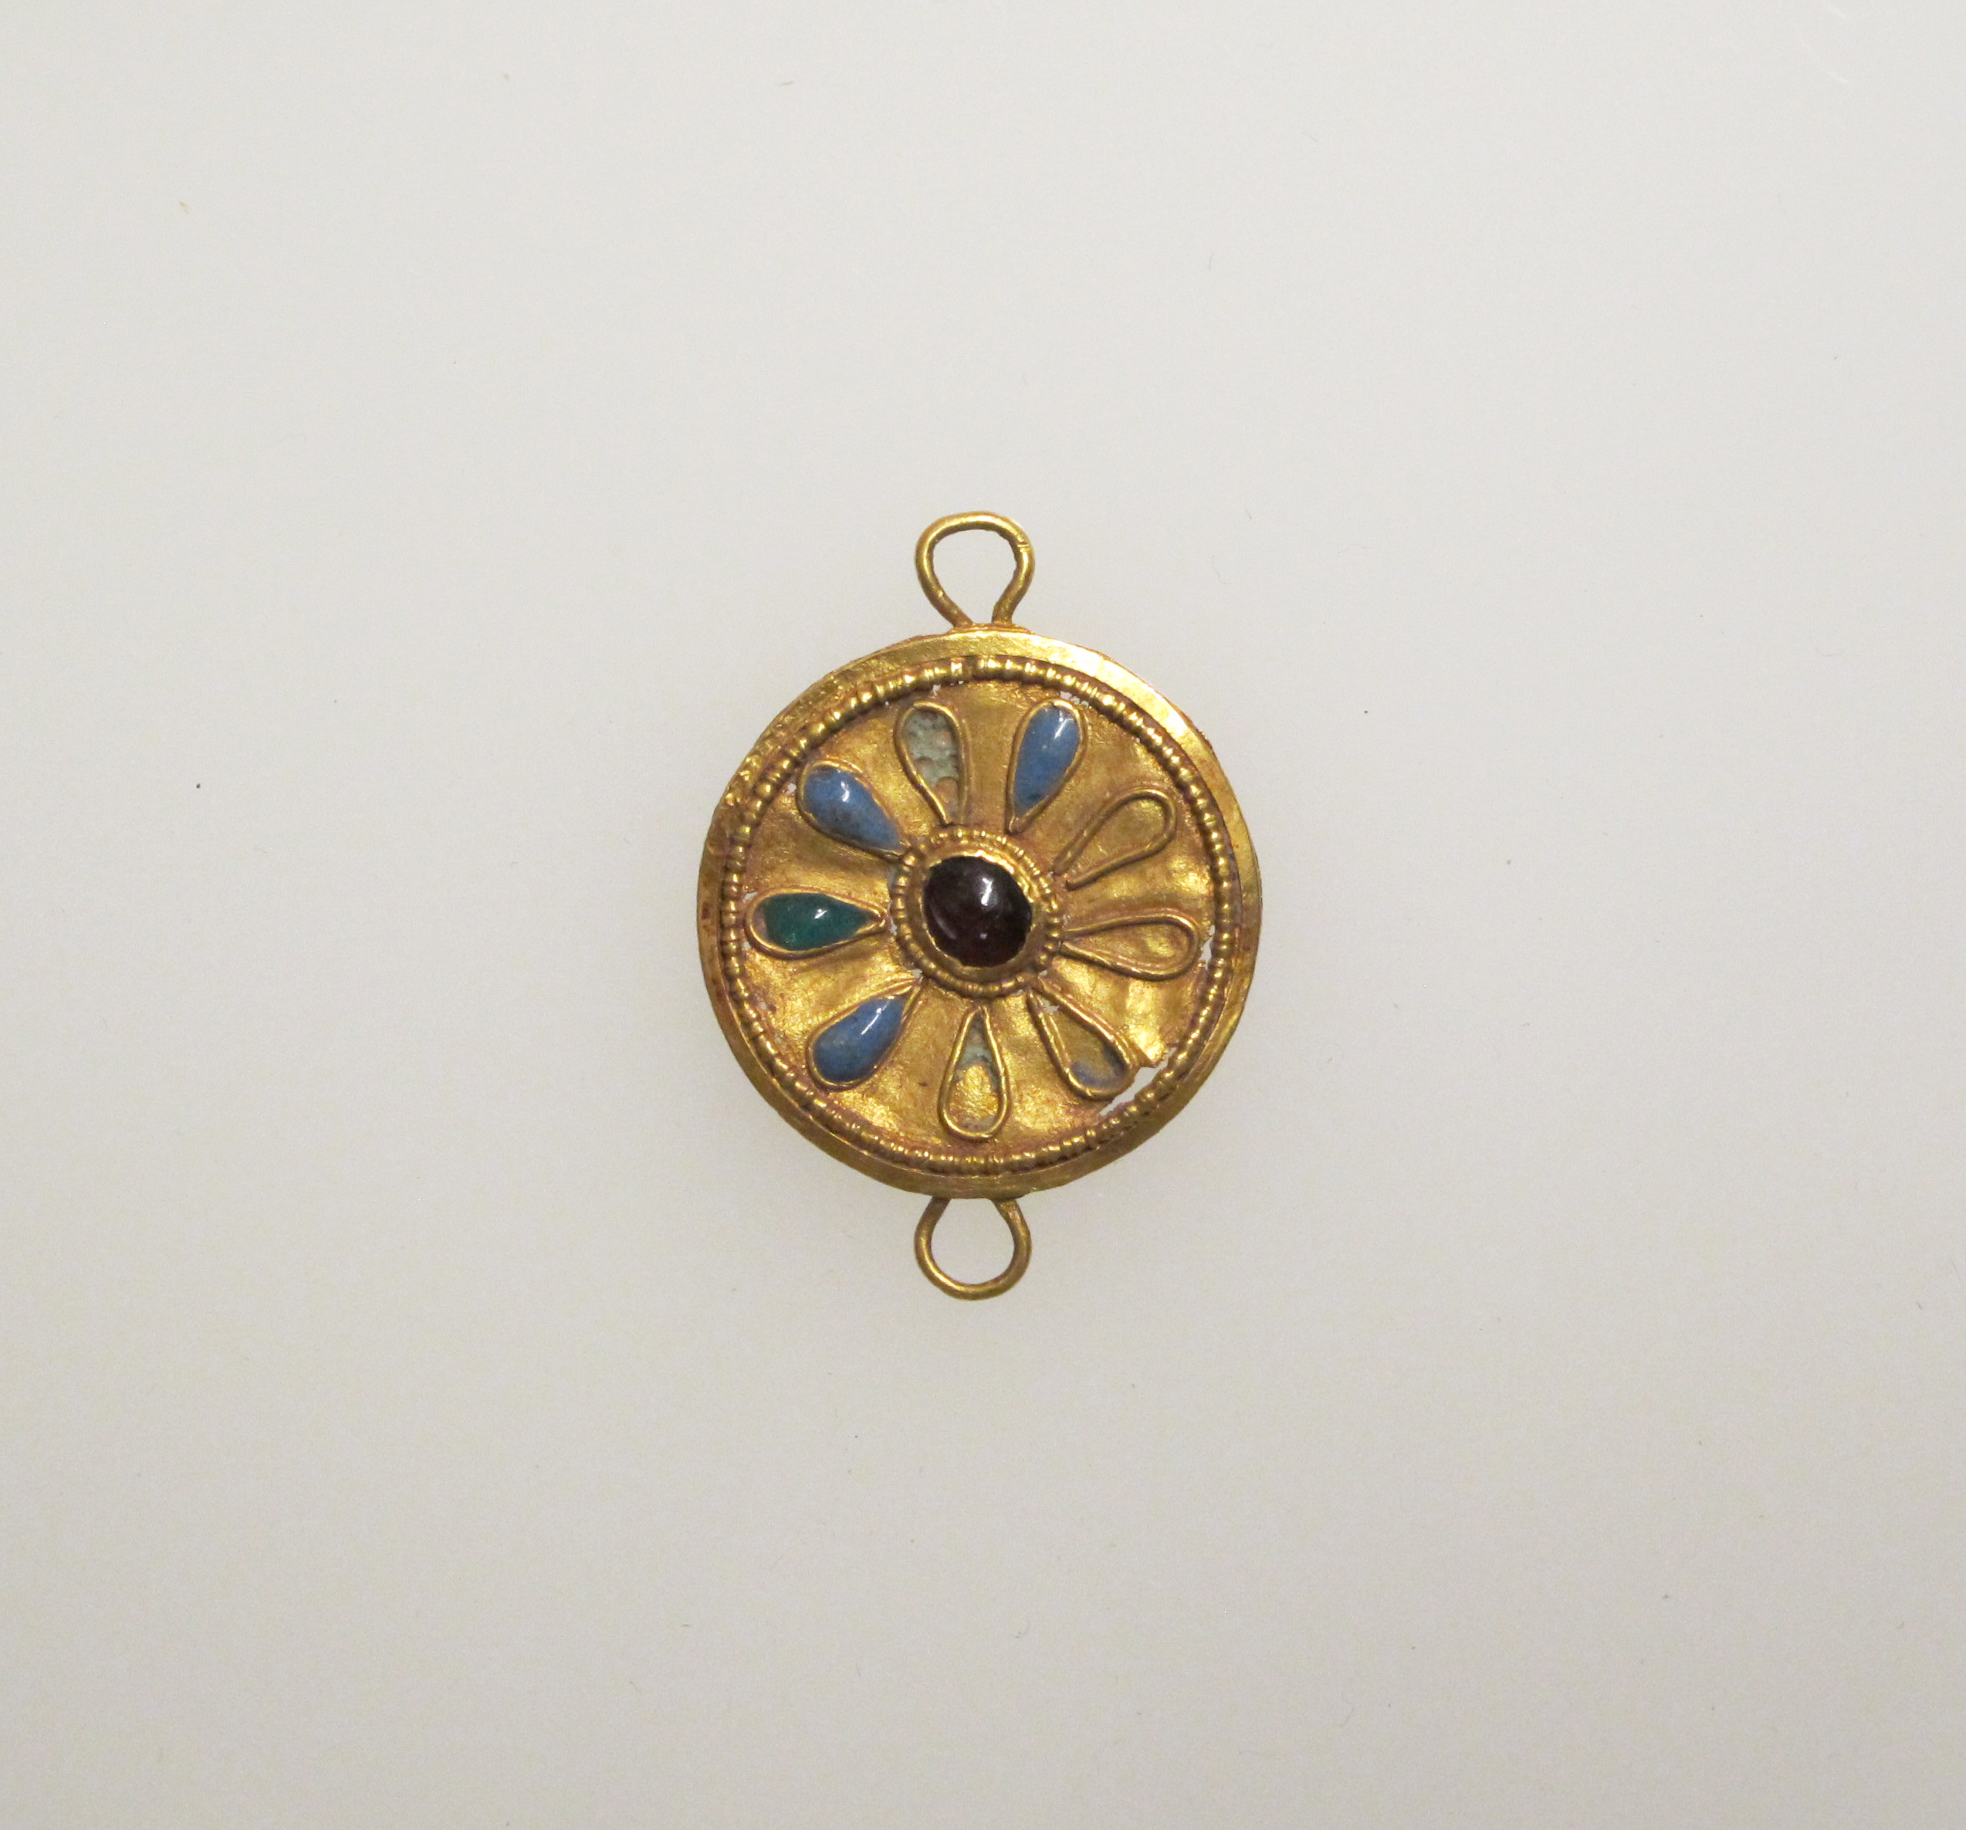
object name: roundel, medallion with paste inlay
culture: roman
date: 101-300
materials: glass, gold, paste